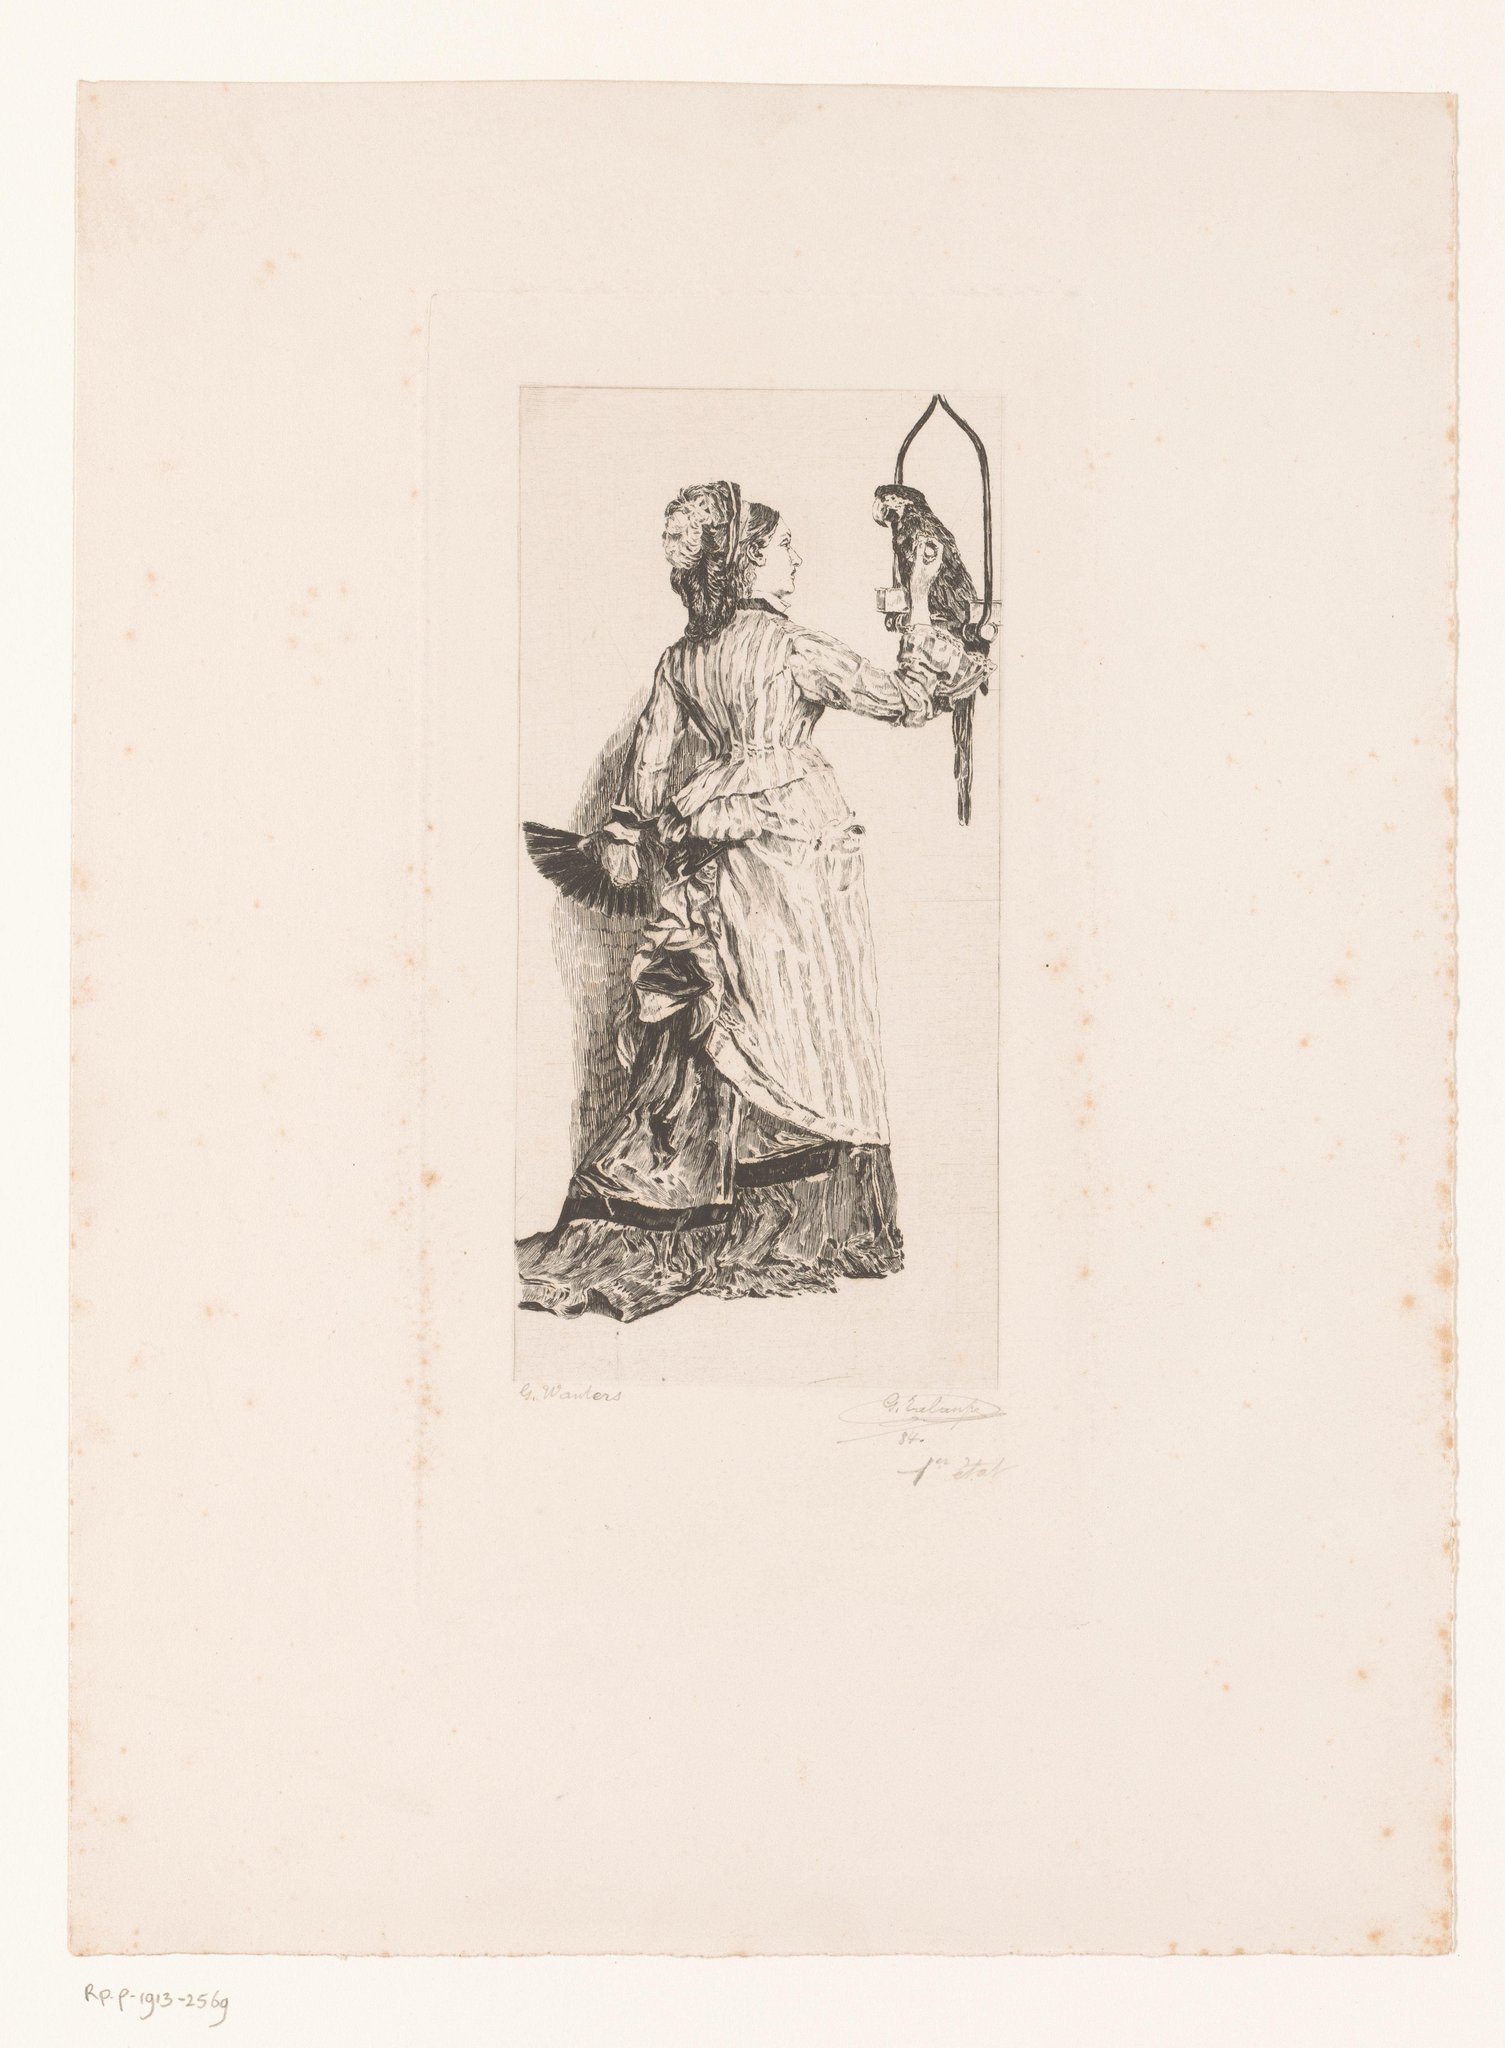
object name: print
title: Vrouw met waaier bij een papegaai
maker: gaston talaupe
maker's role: print maker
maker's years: 1865-1933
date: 1884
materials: paper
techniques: etching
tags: adult woman, ornamental birds: parrot, fan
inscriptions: collector's mark: Lugt 2228, inscription: ‘G. Wauters; 84. 1e état’